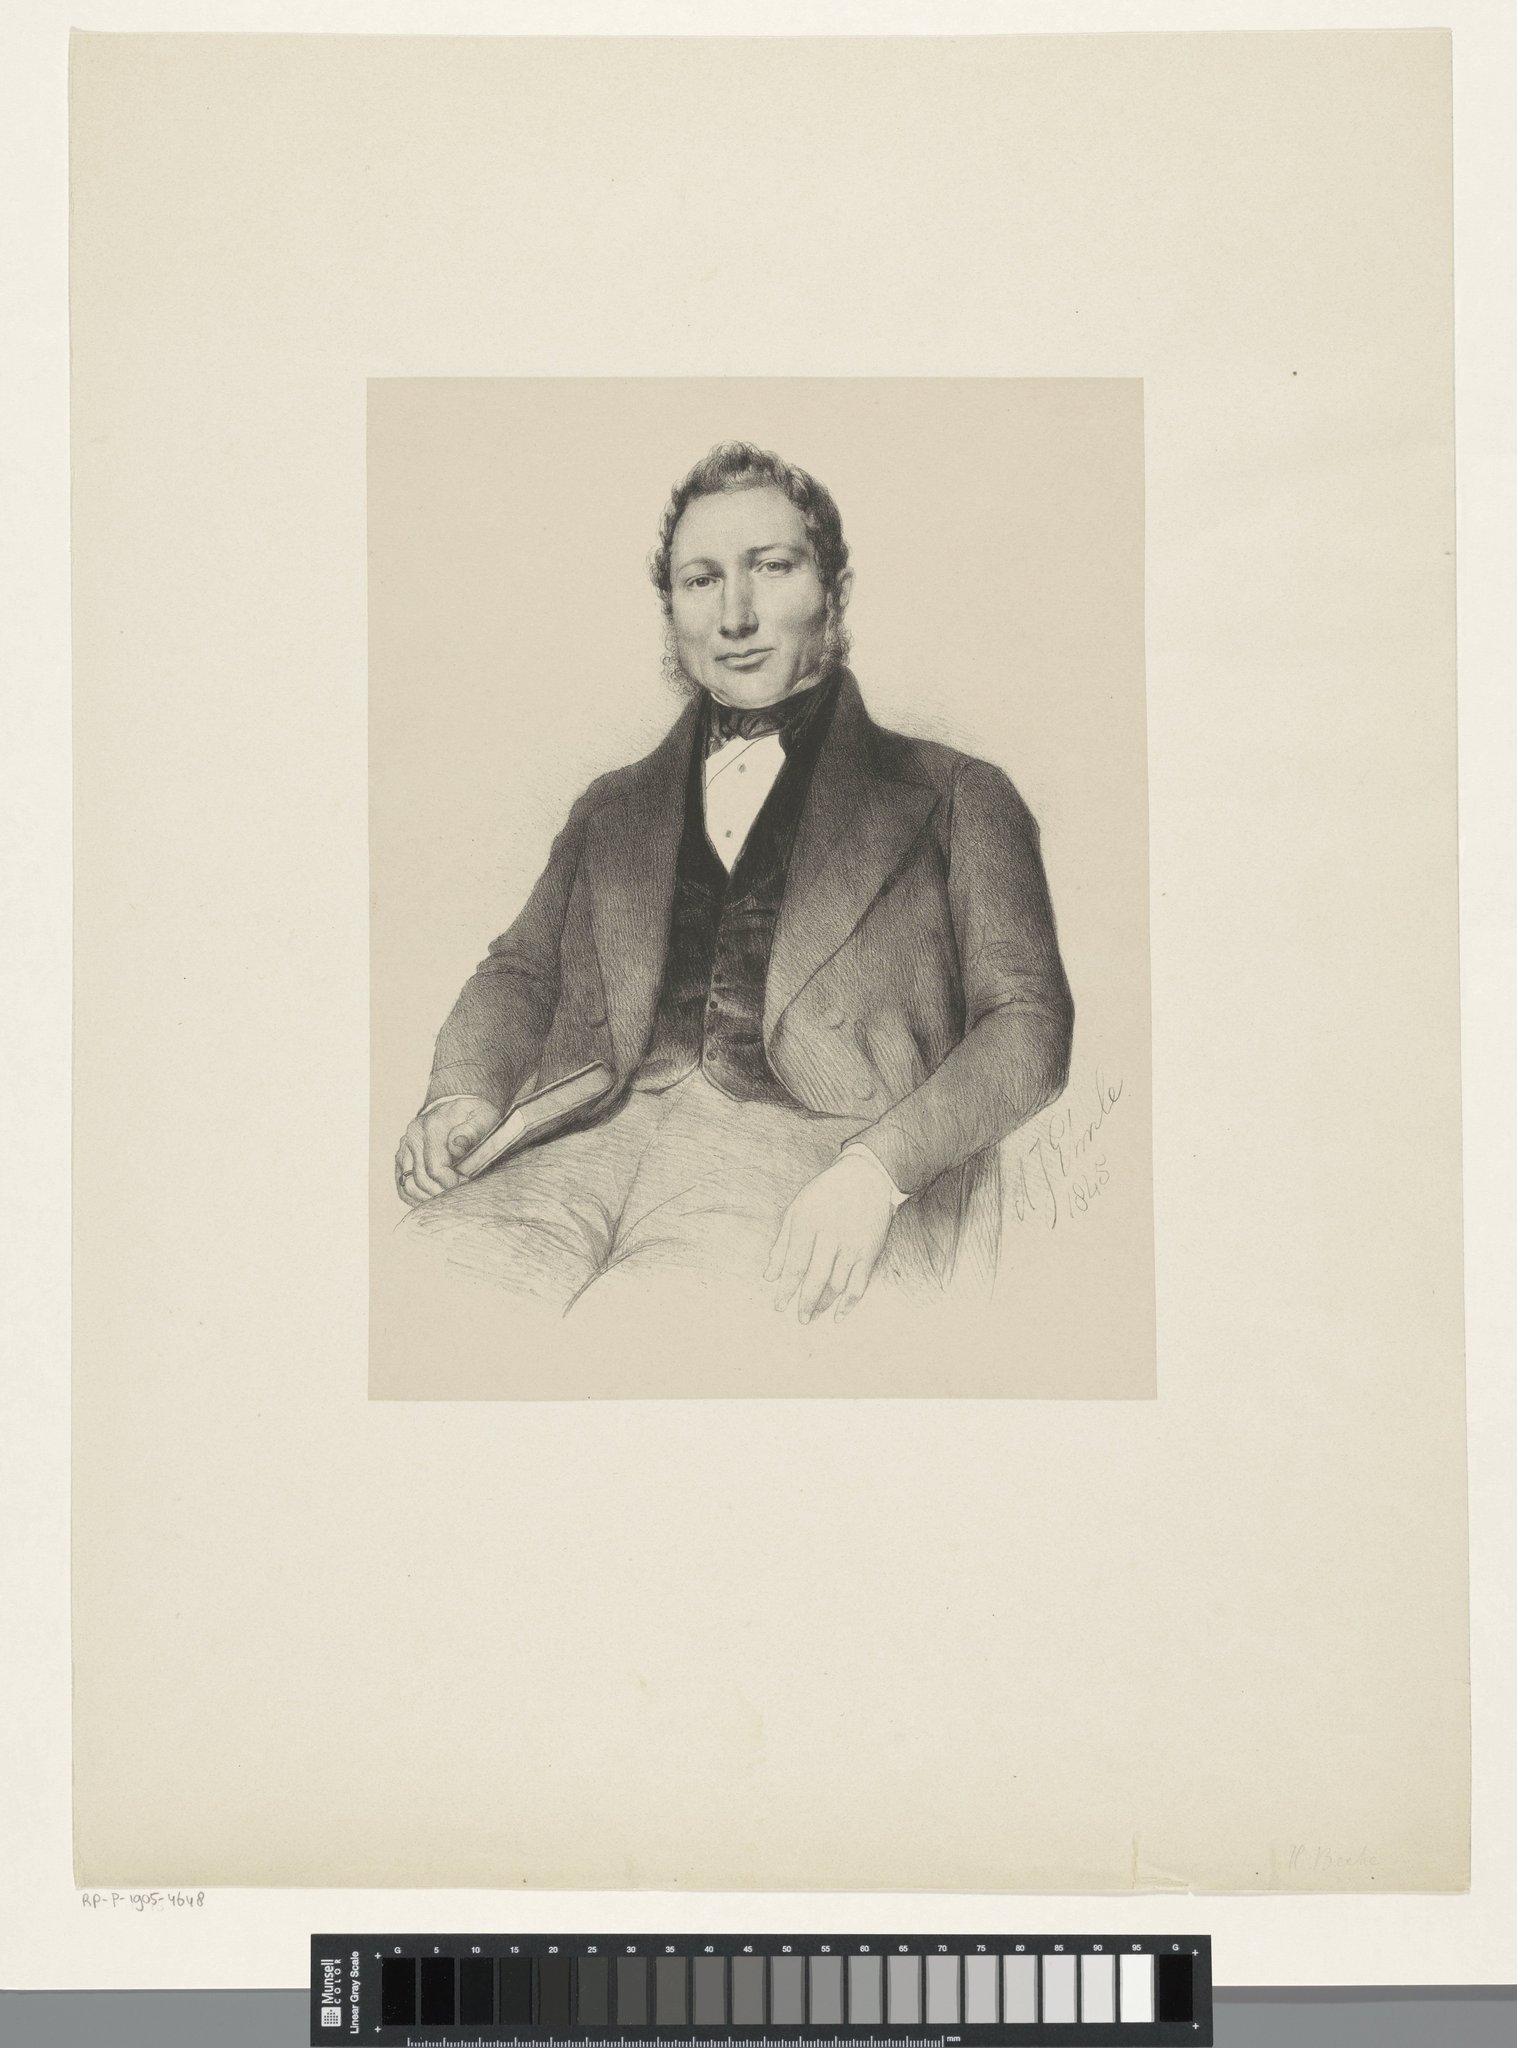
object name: print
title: Portret van H. Beeke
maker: adrianus johannes ehnle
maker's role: draughtsman, print maker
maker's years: 1819-1863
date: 1845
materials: paper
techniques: lithograph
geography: netherlands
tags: book, historical persons (+ half-length portrait)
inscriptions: collector's mark: Lugt 2228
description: De geportretteerde zit in een stoel met een boek in zijn rechterhand.